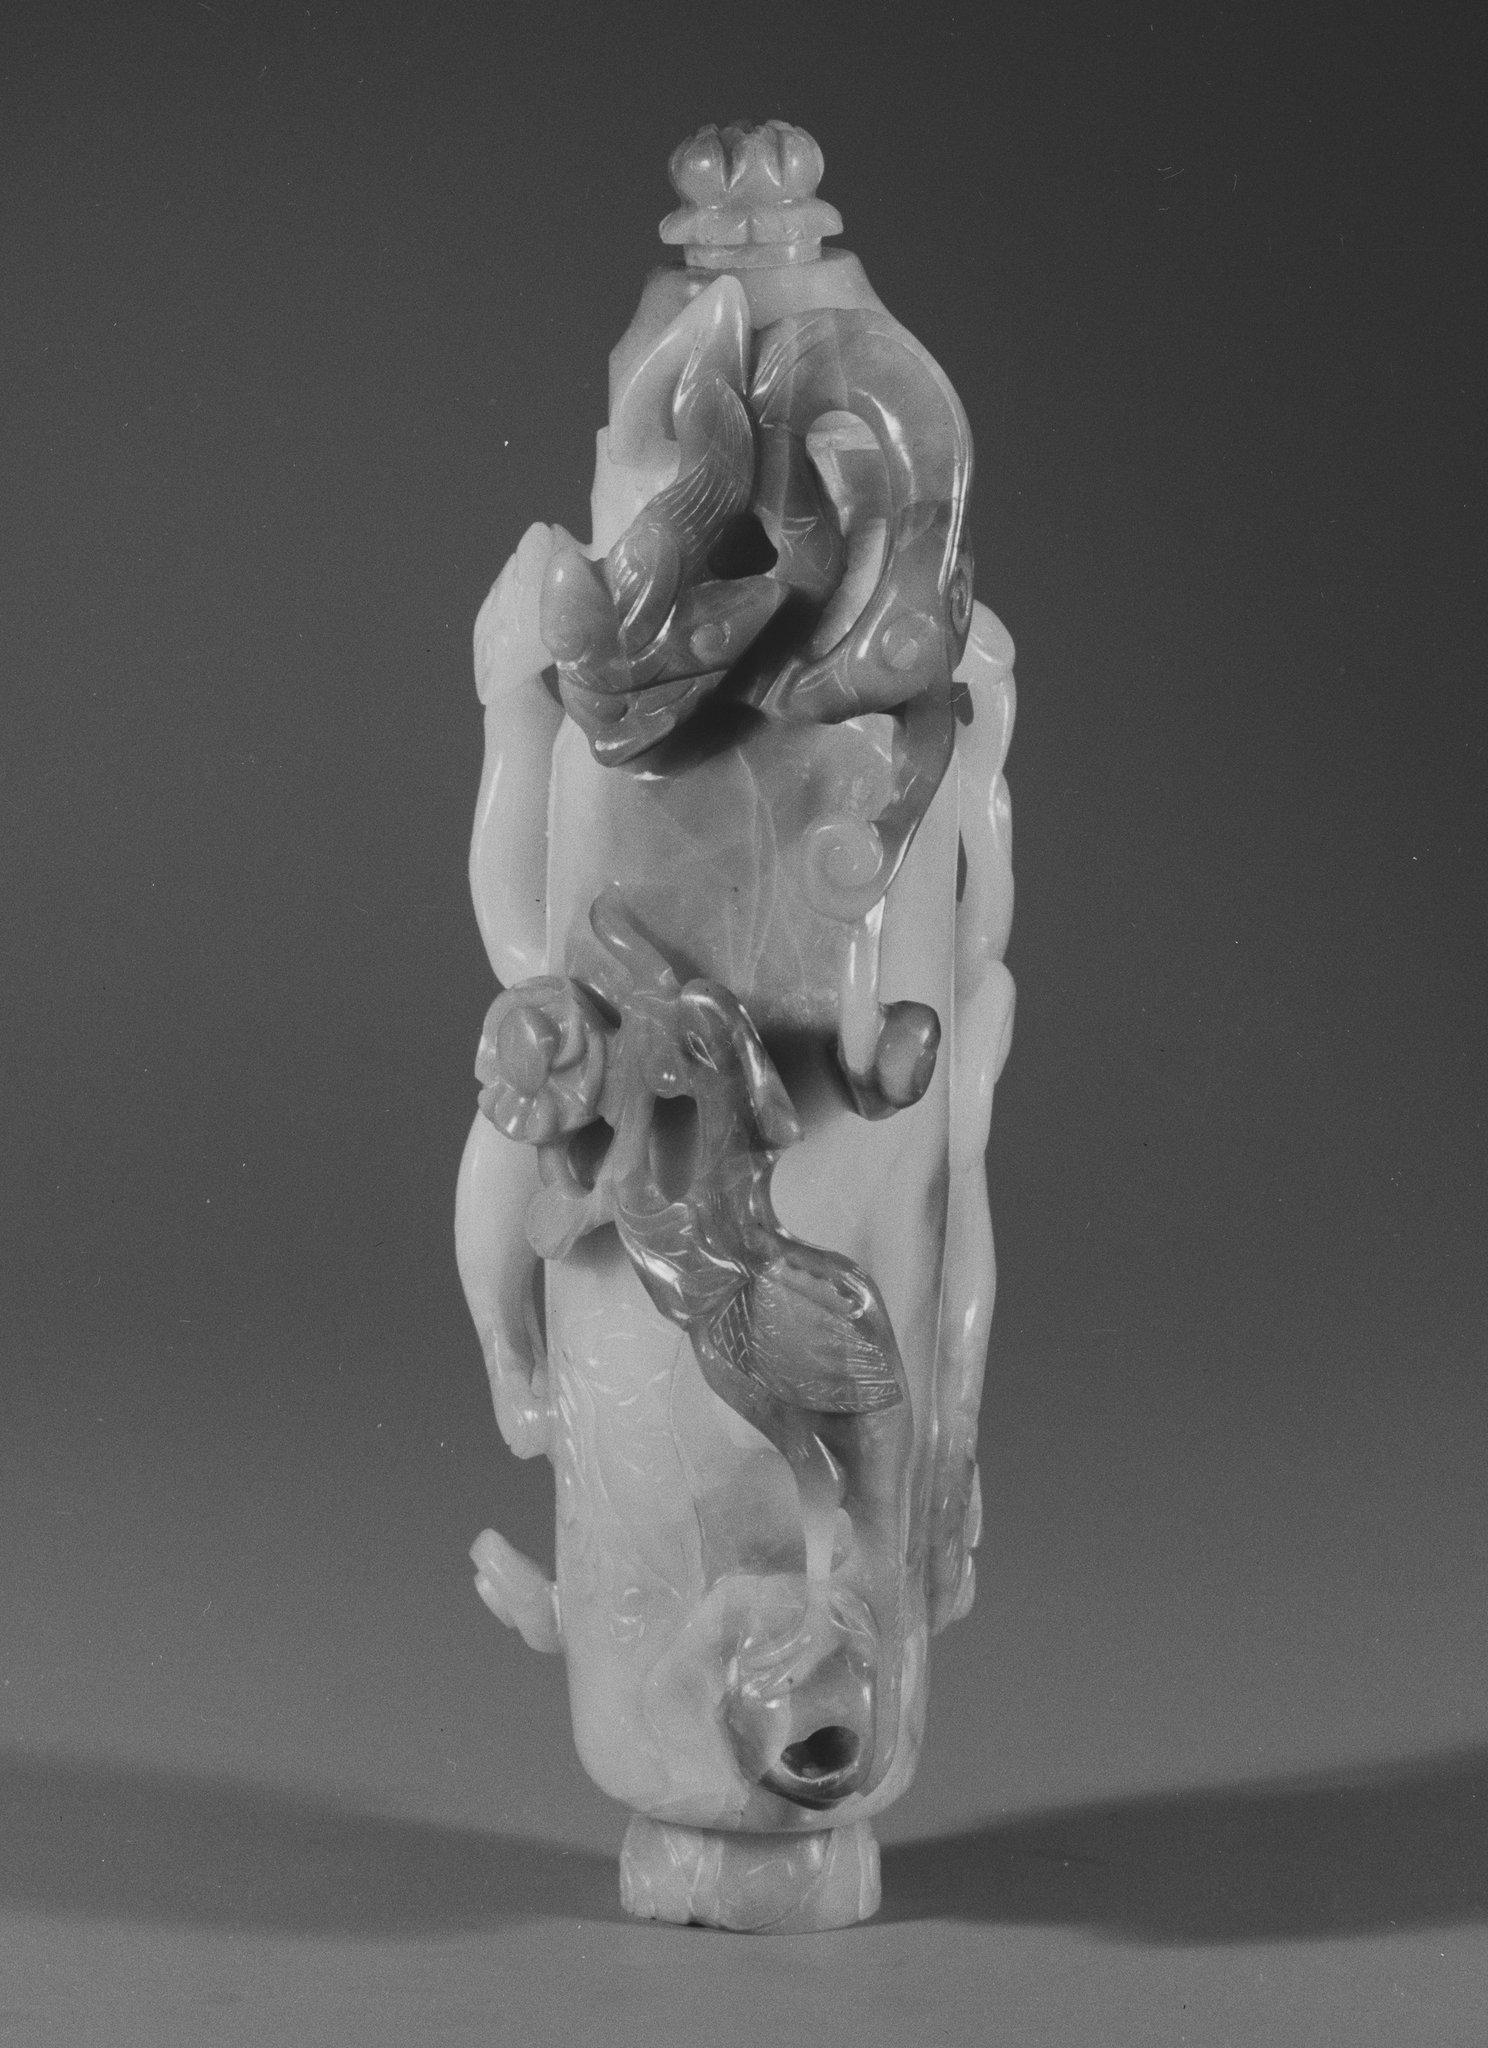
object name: covered vase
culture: chinese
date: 1867-1900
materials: jade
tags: dragons